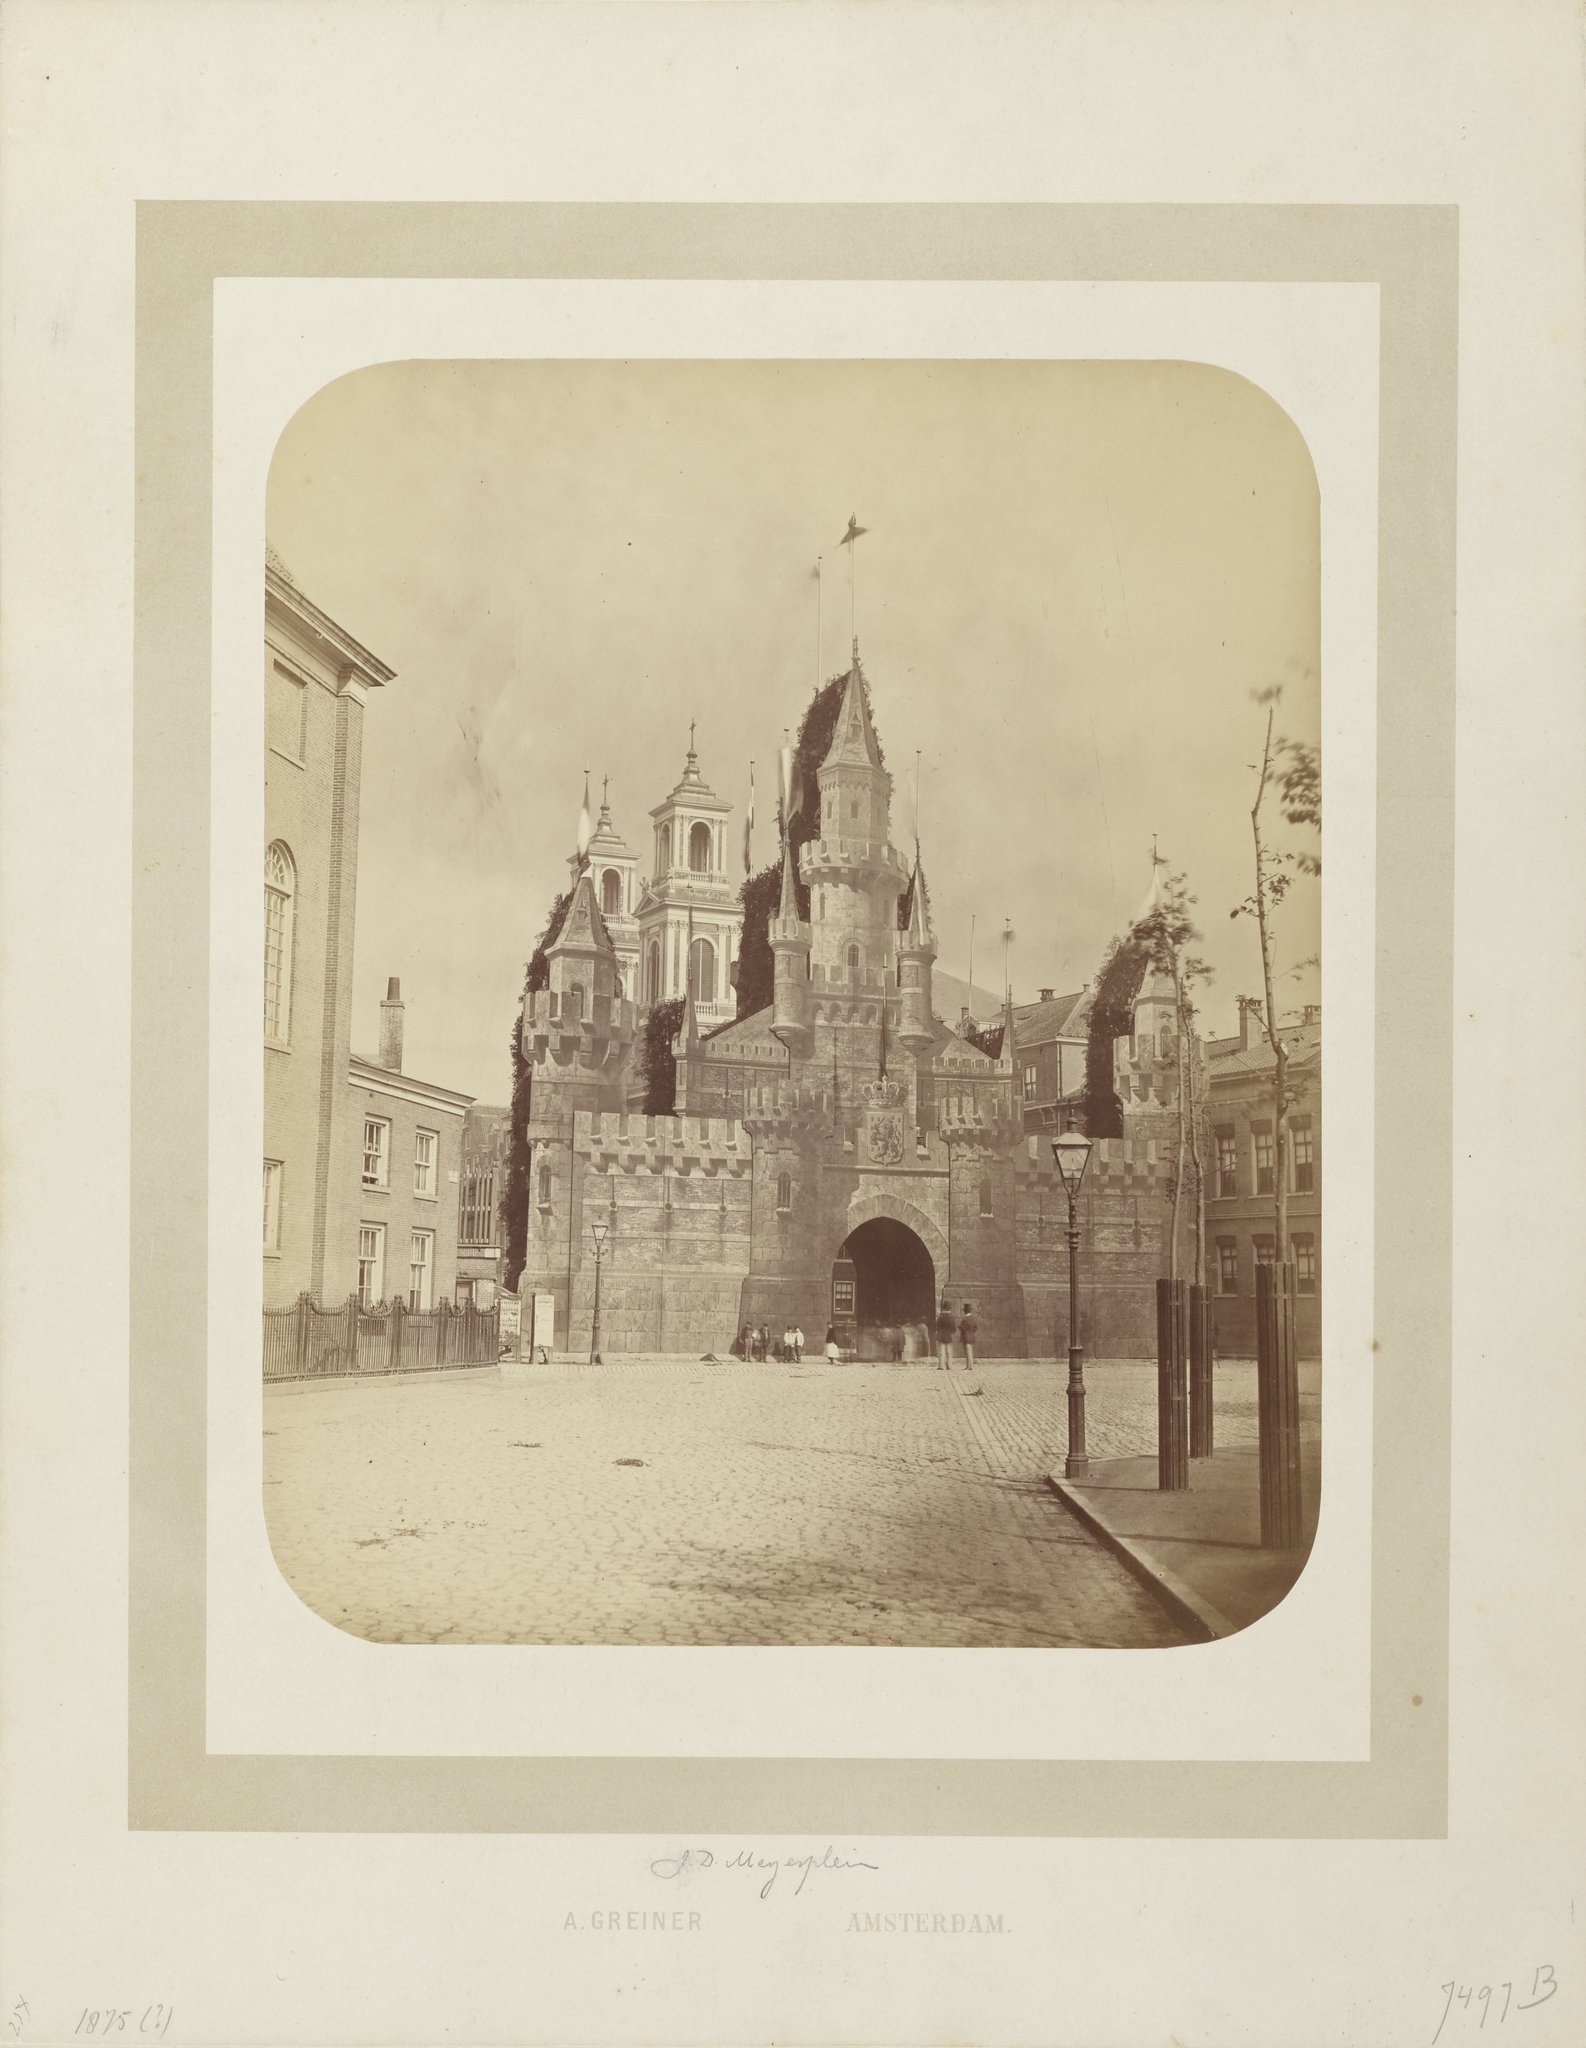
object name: photograph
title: Poort, tijdelijk opgetrokken op het Jonas Daniël Meyerplein te Amsterdam, ca. 1875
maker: albert greiner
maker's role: fotograaf, fotostudio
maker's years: 1833-1890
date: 1872-1878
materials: cardboard, paper, photographic support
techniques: albumen print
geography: amsterdam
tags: backdrop, gate, entrance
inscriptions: collector's mark: Lugt 2228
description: Oude stadspoort met kantelen en torens, tijdelijk opgetrokken op het Jonas Daniël Meyerplein te Amsterdam, met de Mozes en Aäronkerk op de achtergrond, ca. 1875.